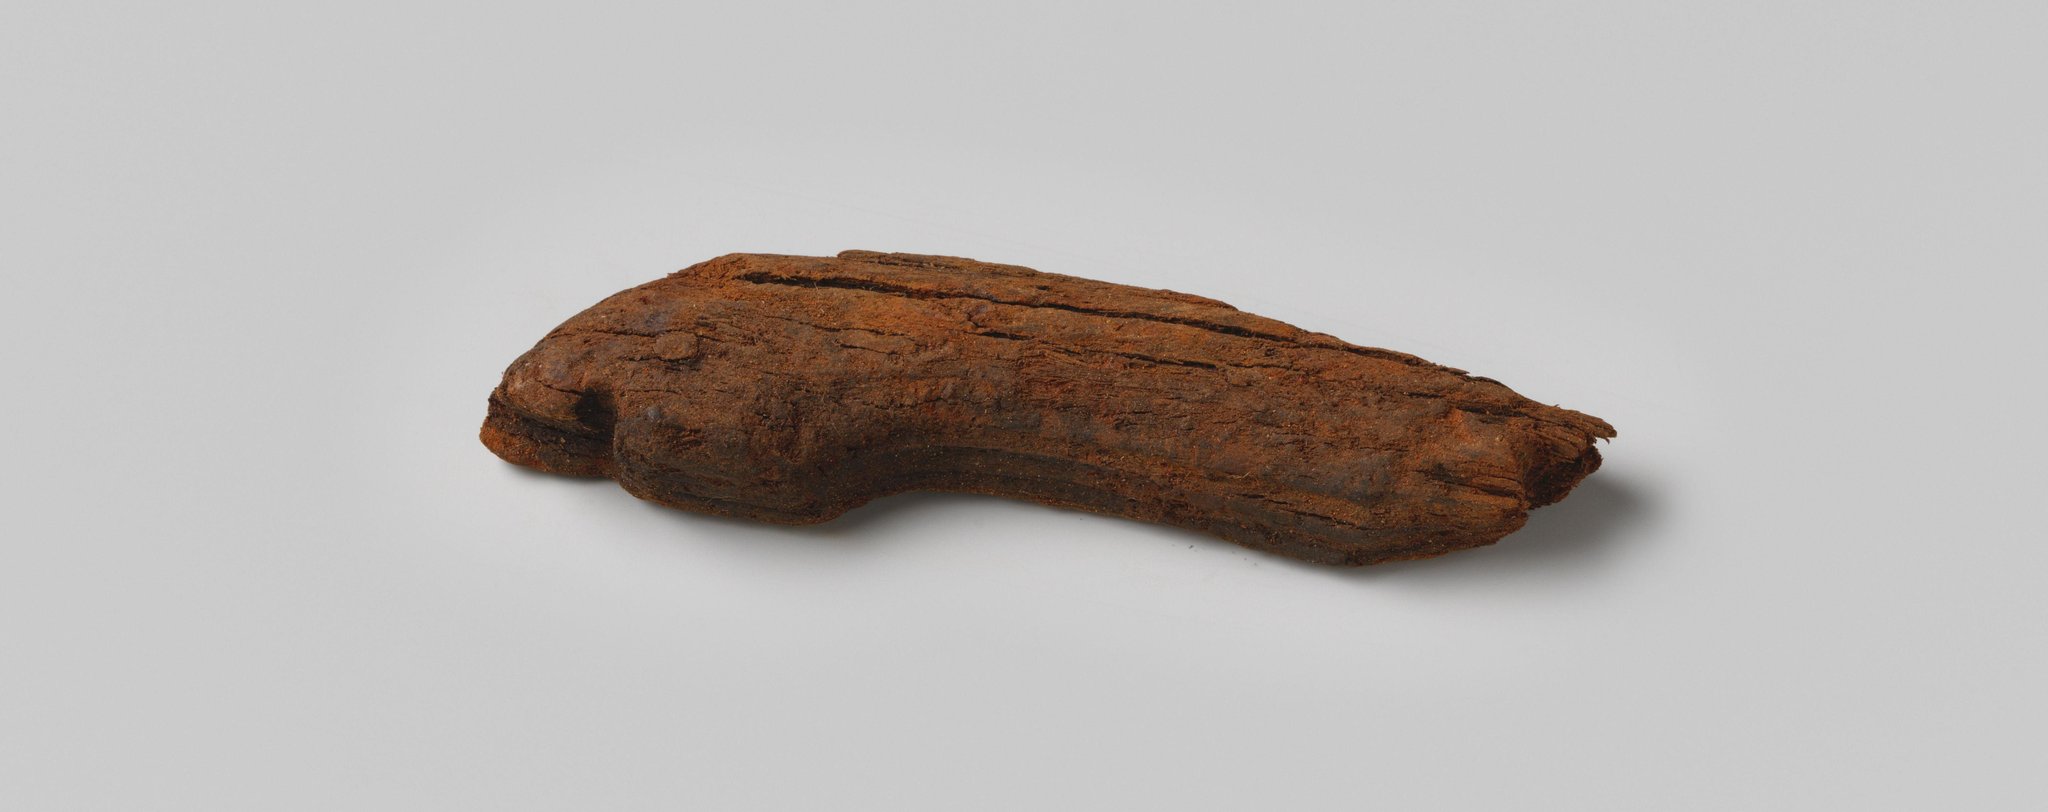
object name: fragment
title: Fragment van hout uit het wrak van de Oost-Indiëvaarder Hollandia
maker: Anonymous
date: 1700-1743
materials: wood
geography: netherlands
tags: verenigde oostindische compagnie, hollandia (schip), annet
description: Varied parts or fragments, unidentified and miscellaneous parts or fragments.